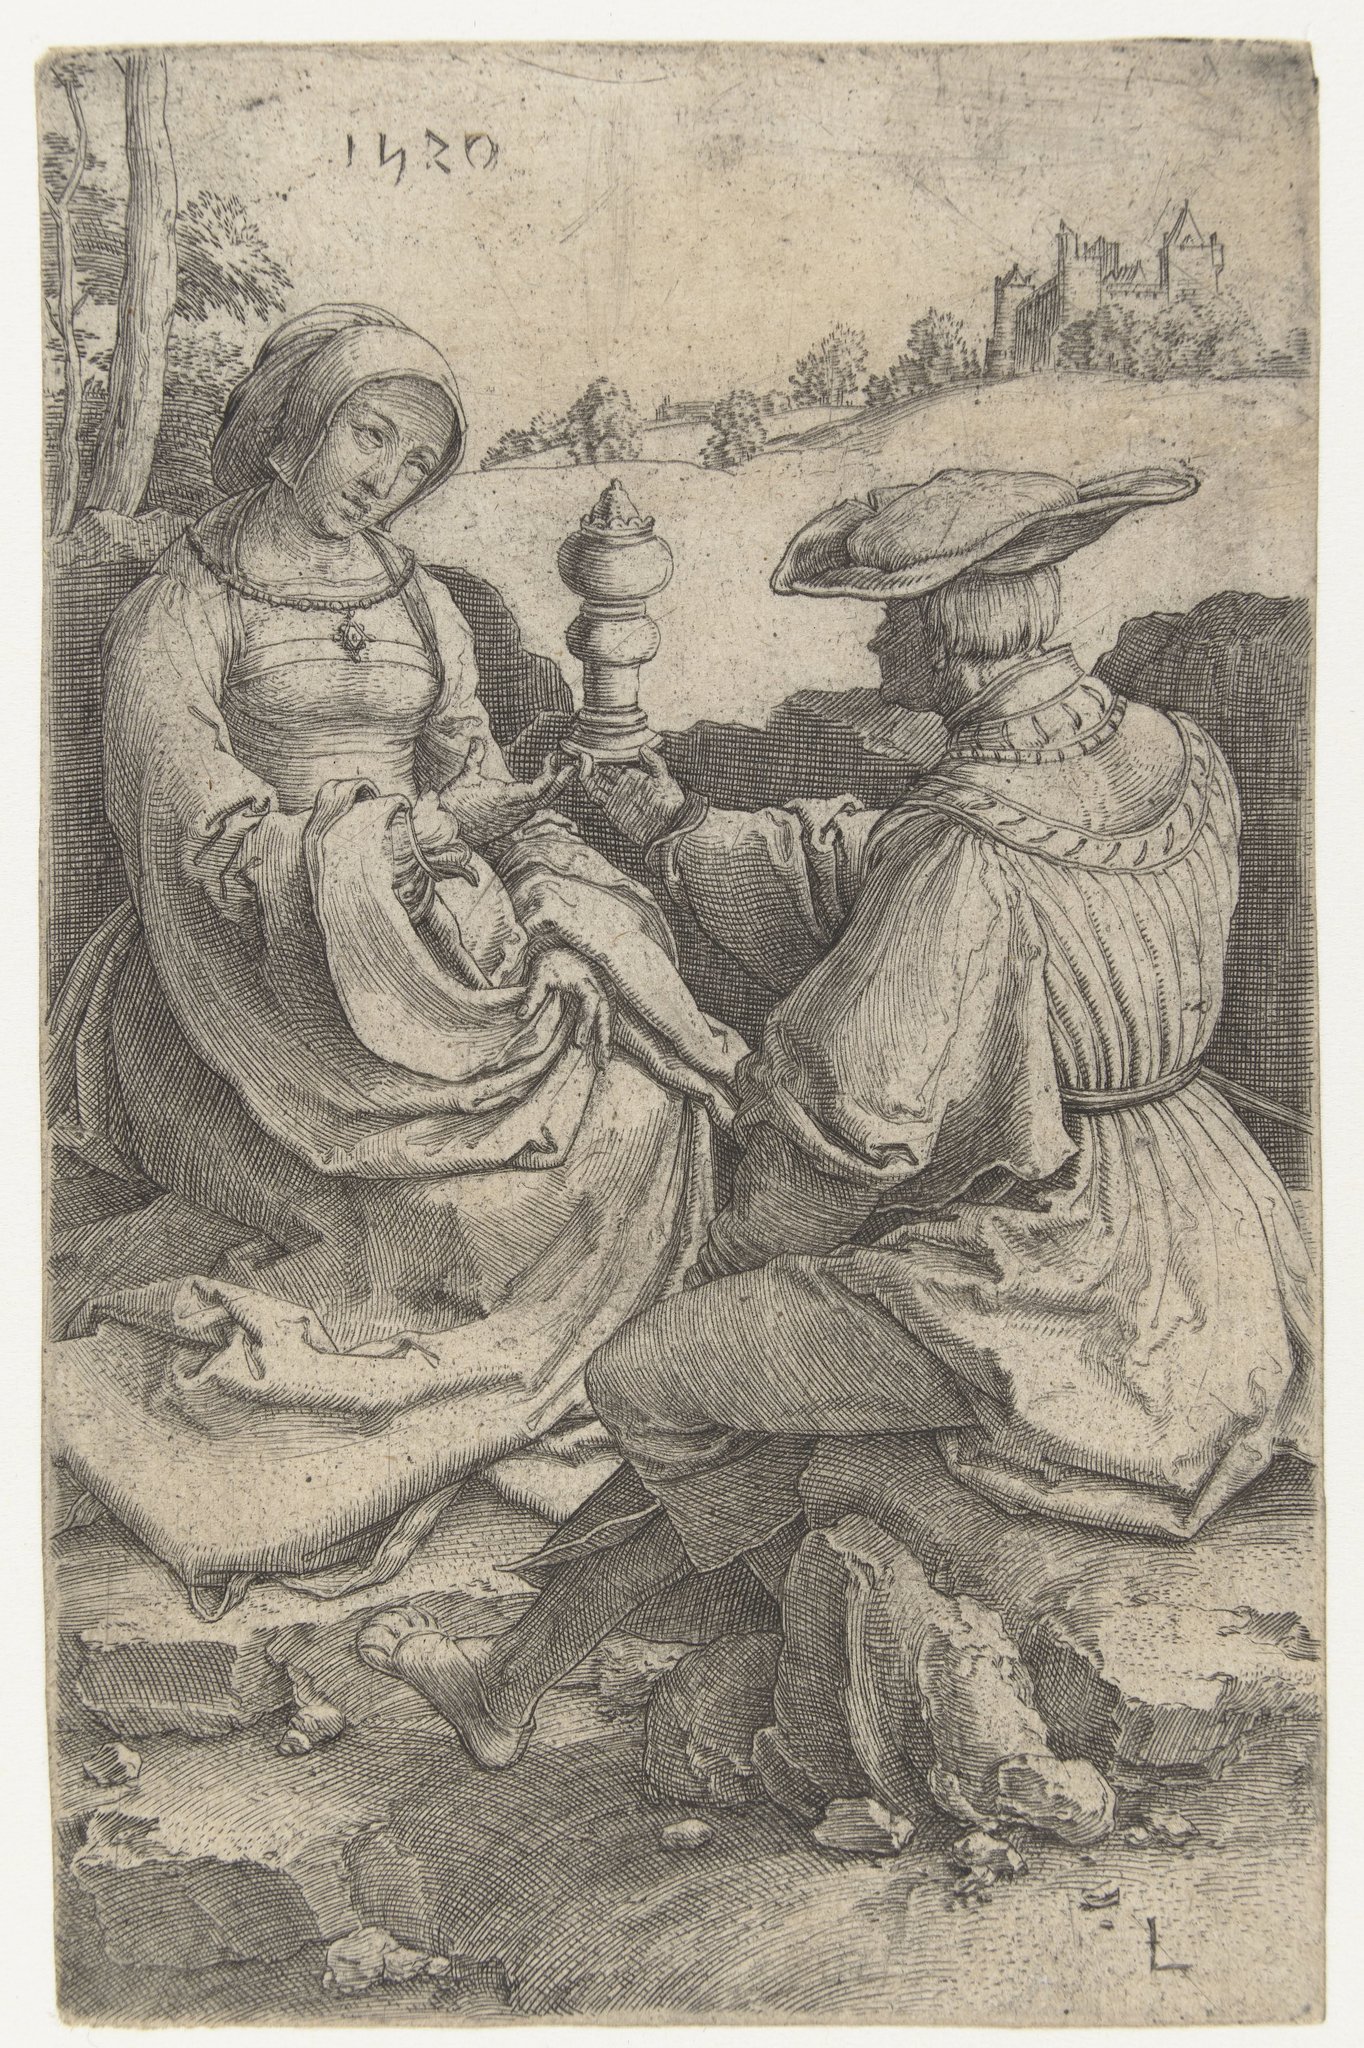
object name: print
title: Heer en dame gezeten in een landschap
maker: lucas van leyden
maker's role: draughtsman, painter, print maker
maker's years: 1494-1533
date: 1520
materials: paper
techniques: engraving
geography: low countries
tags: female sex; woman, cup, male sex; man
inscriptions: collector's mark: Lugt 2228a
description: Man en vrouw gezeten in landschap, man overhandigt een beker aan de vrouw.